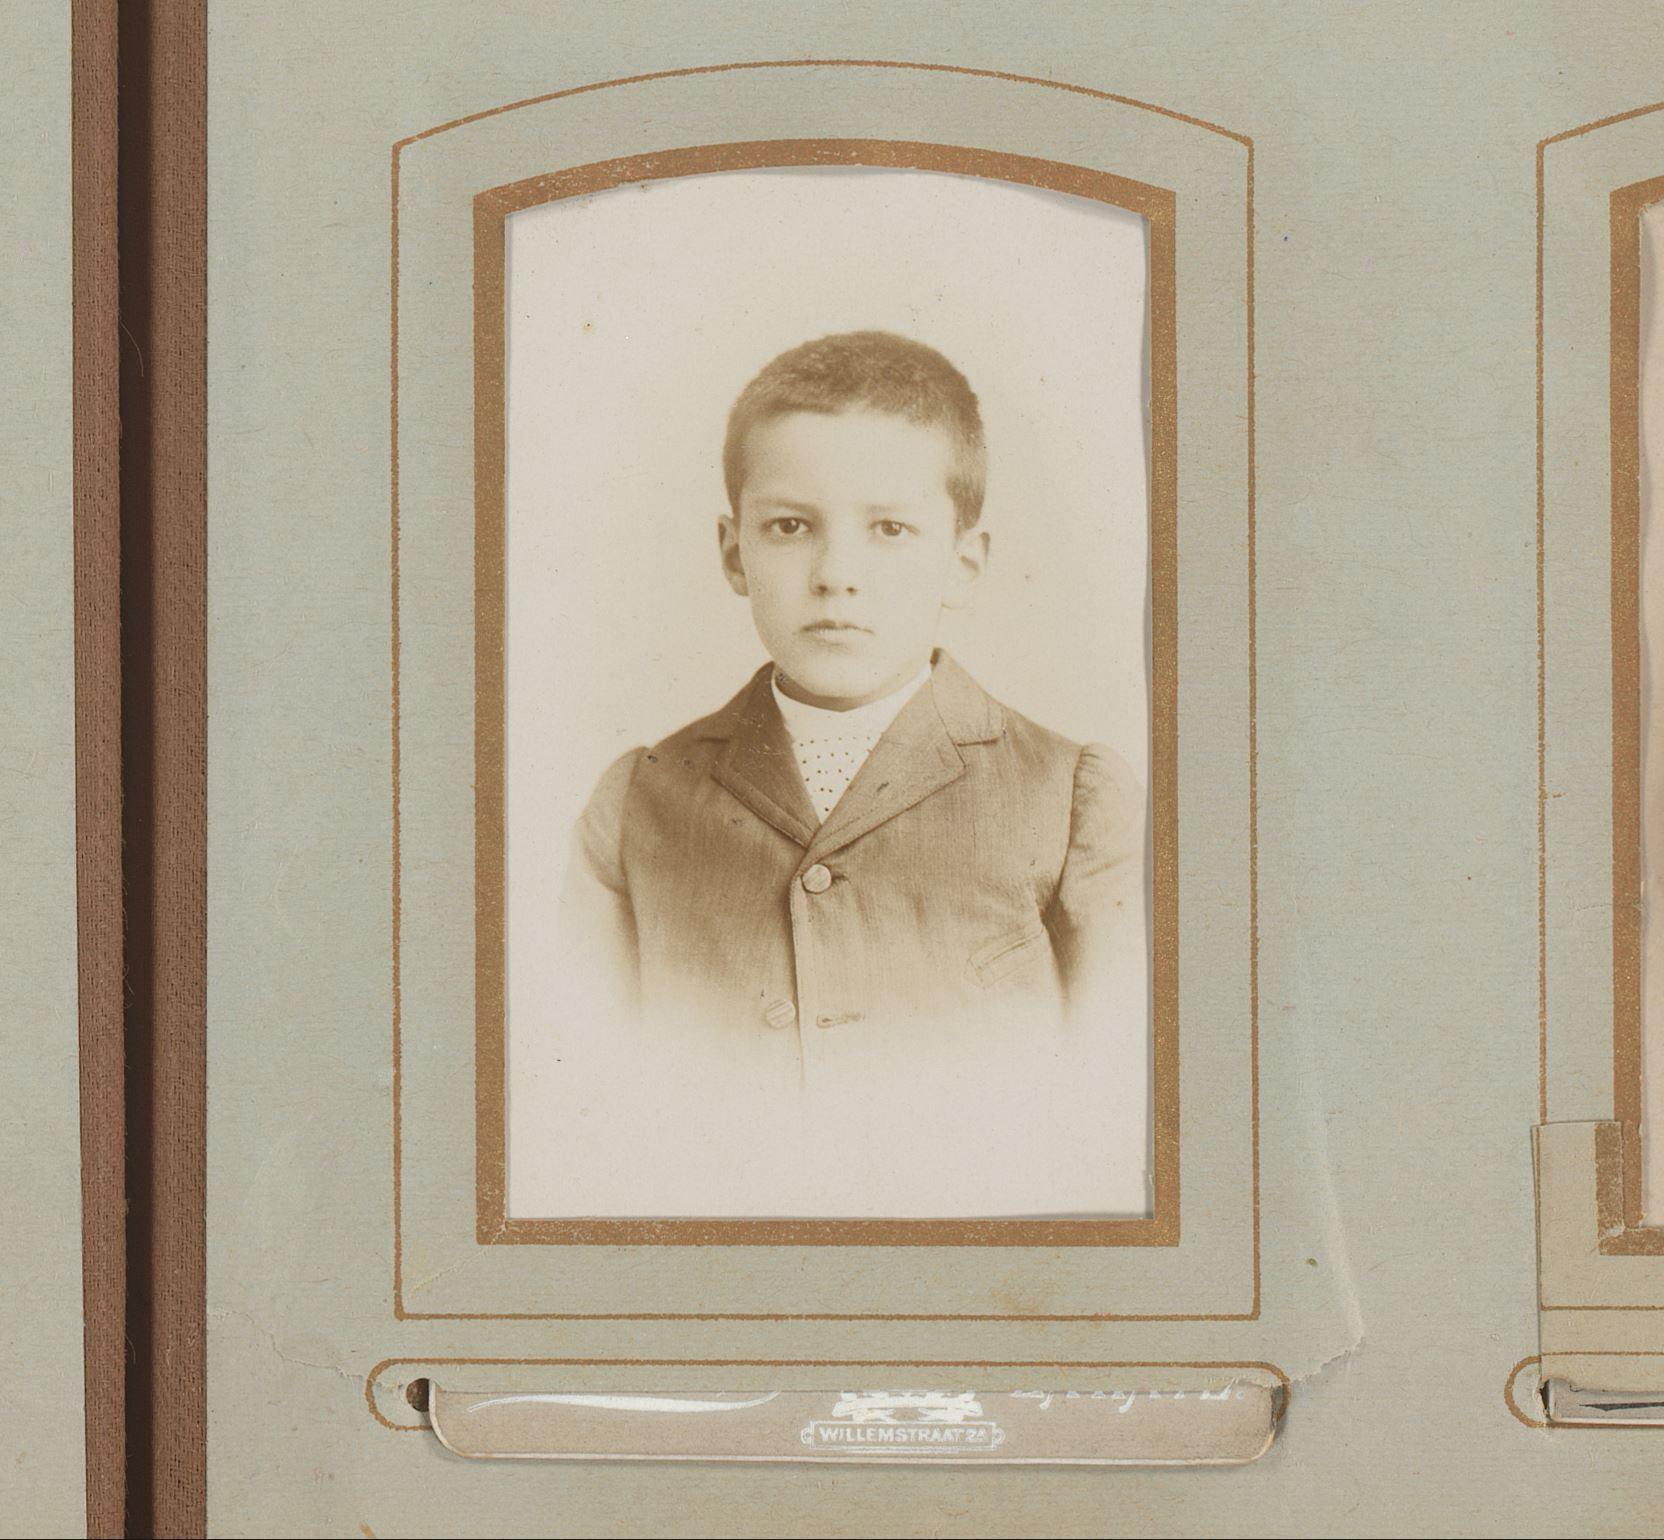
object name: album leaf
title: Portret van een jongen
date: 1880-1903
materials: cardboard, photographic support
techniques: collodion silver print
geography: the hague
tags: boy (child between toddler and youth)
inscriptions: inscription: ‘De Lavieter & Co./ La Haye’